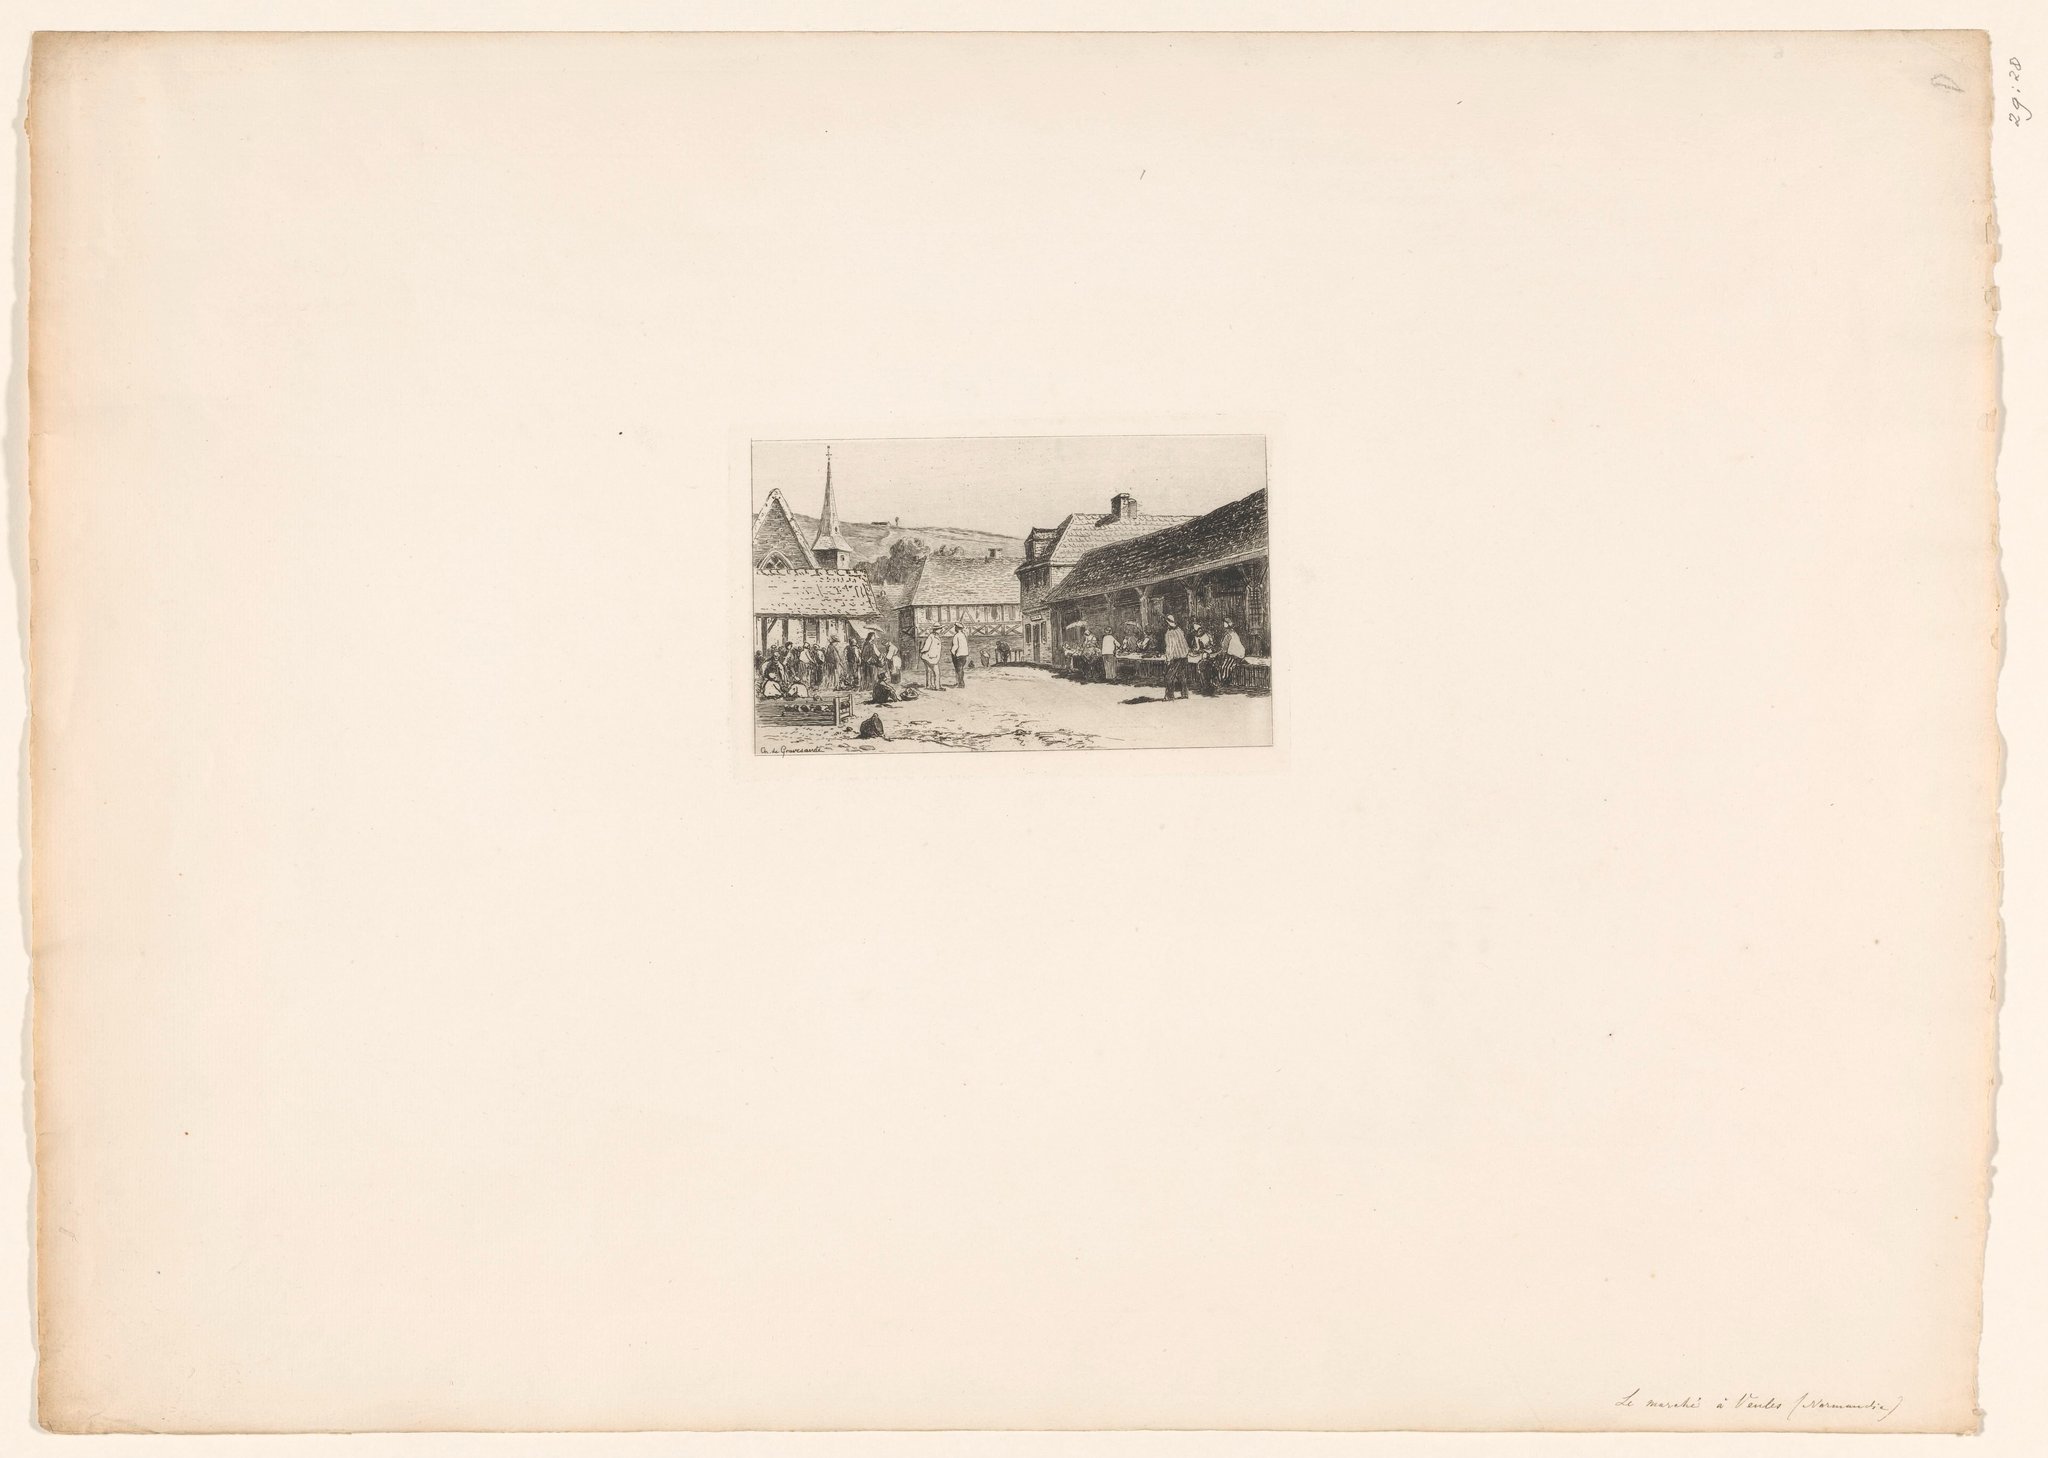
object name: print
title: Markt te Veules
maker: carel nicolaas storm van s-gravesande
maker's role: draughtsman, print maker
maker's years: 1841-1924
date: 1851-1924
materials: paper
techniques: etching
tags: market, prospect of village, silhouette of village (+ city(-scape) with figures, staffage)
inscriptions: collector's mark: Lugt 2233, collector's mark: Lugt 2228